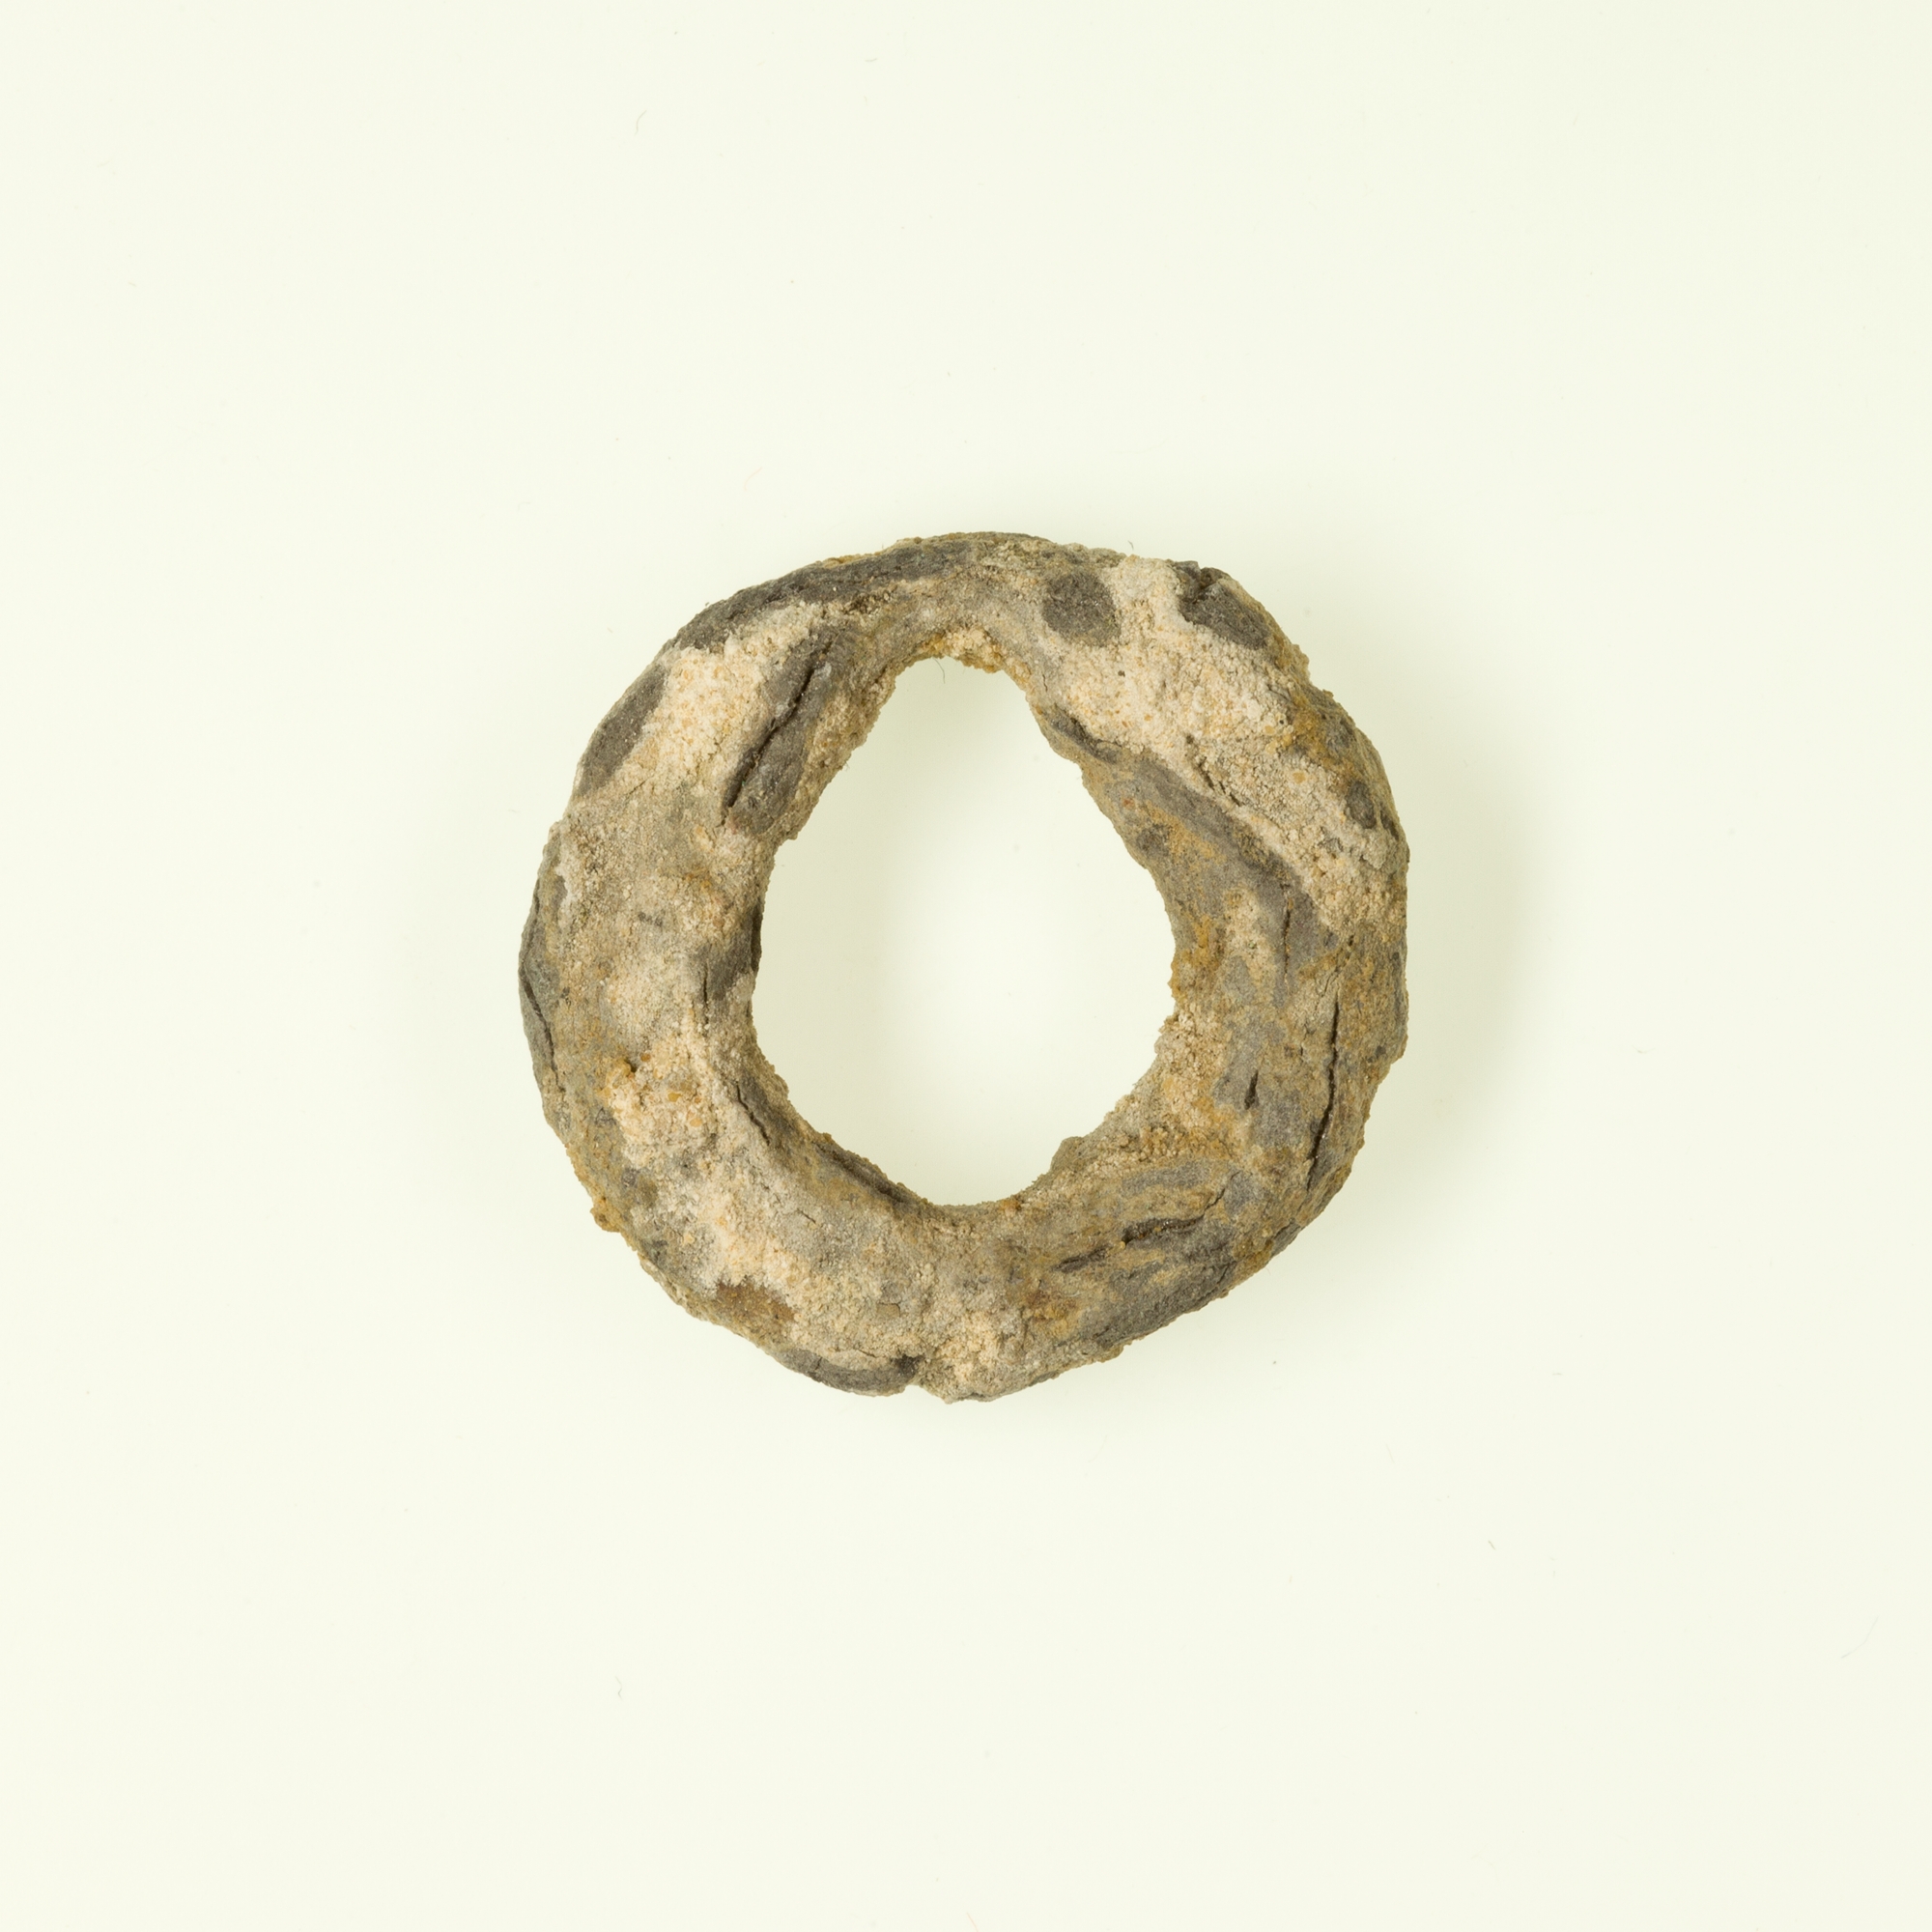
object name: household ring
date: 1295-1070 BCE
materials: lead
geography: egypt